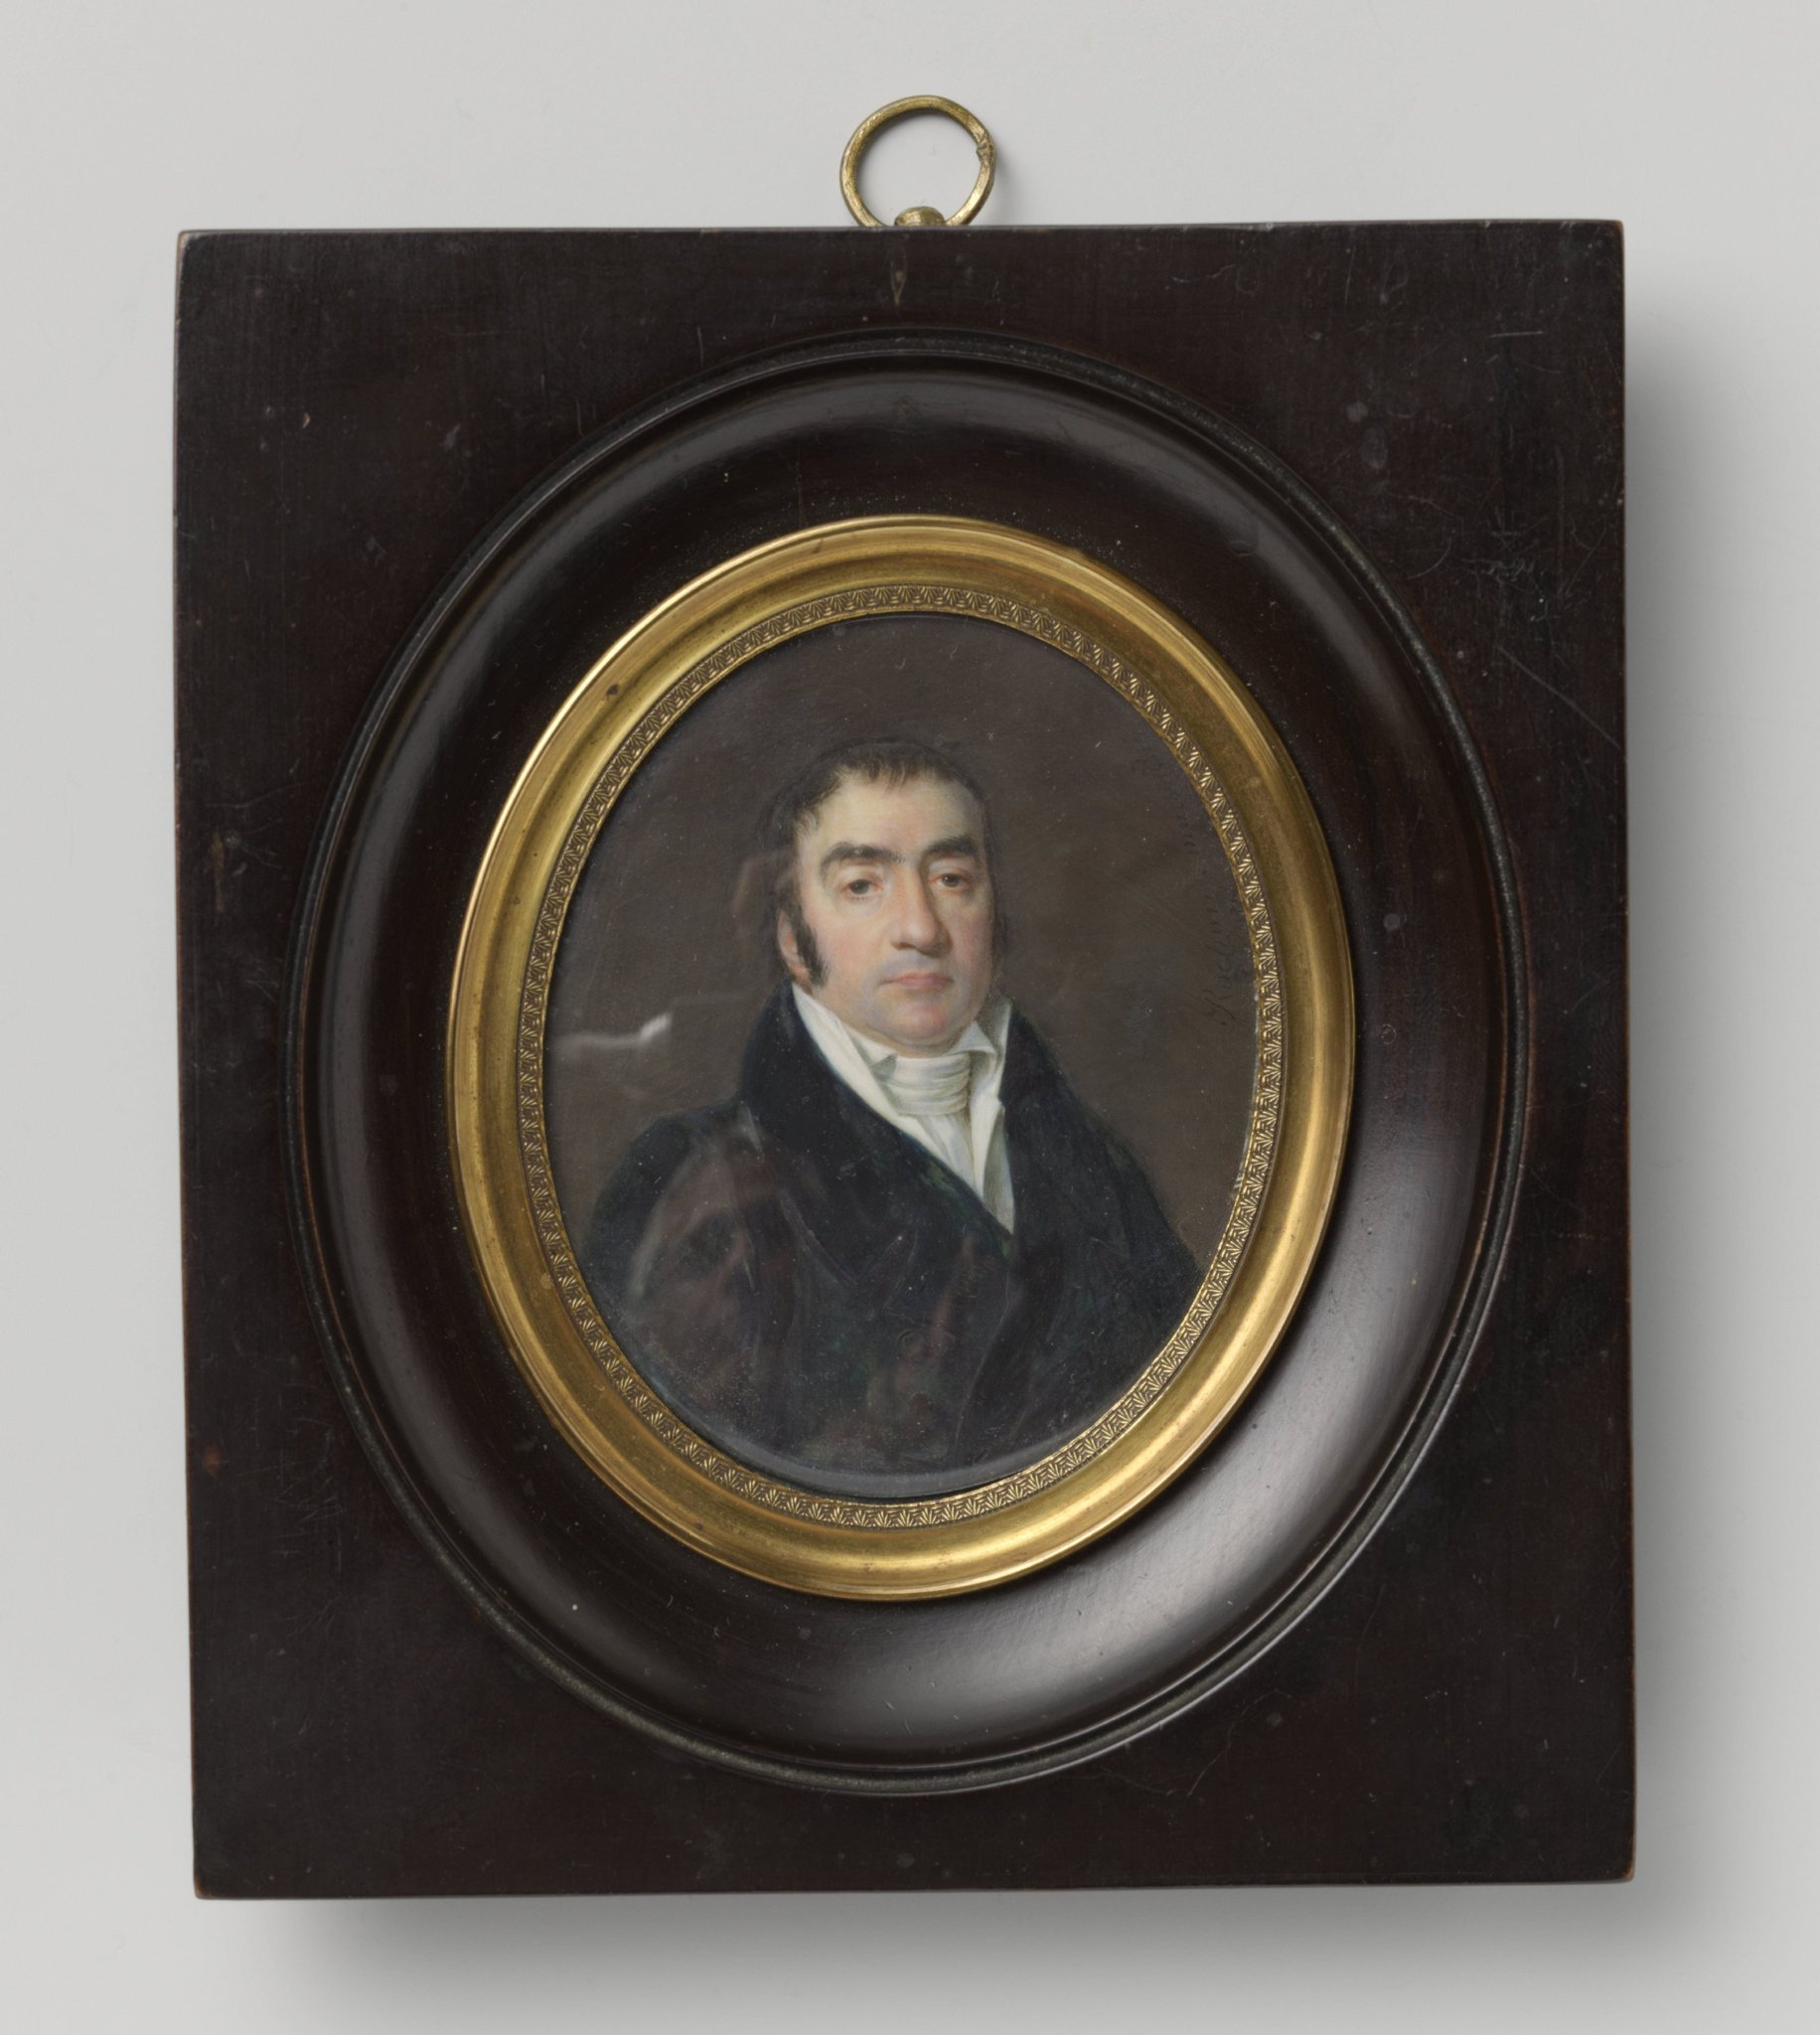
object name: painting, miniature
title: Portret van Herman Willem Daendels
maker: simon jacques rochard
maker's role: painter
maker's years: 1788-1872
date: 1815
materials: wood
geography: paris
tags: herman willem daendels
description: Ovaal portret van Herman Willem Daendels in rechthoekige houten lijst. Borststuk van een man, het hoofd naar links gewend, in zwarte jas. Vermoedelijk gemaakt na Daendels' terugkomst uit Rusland.